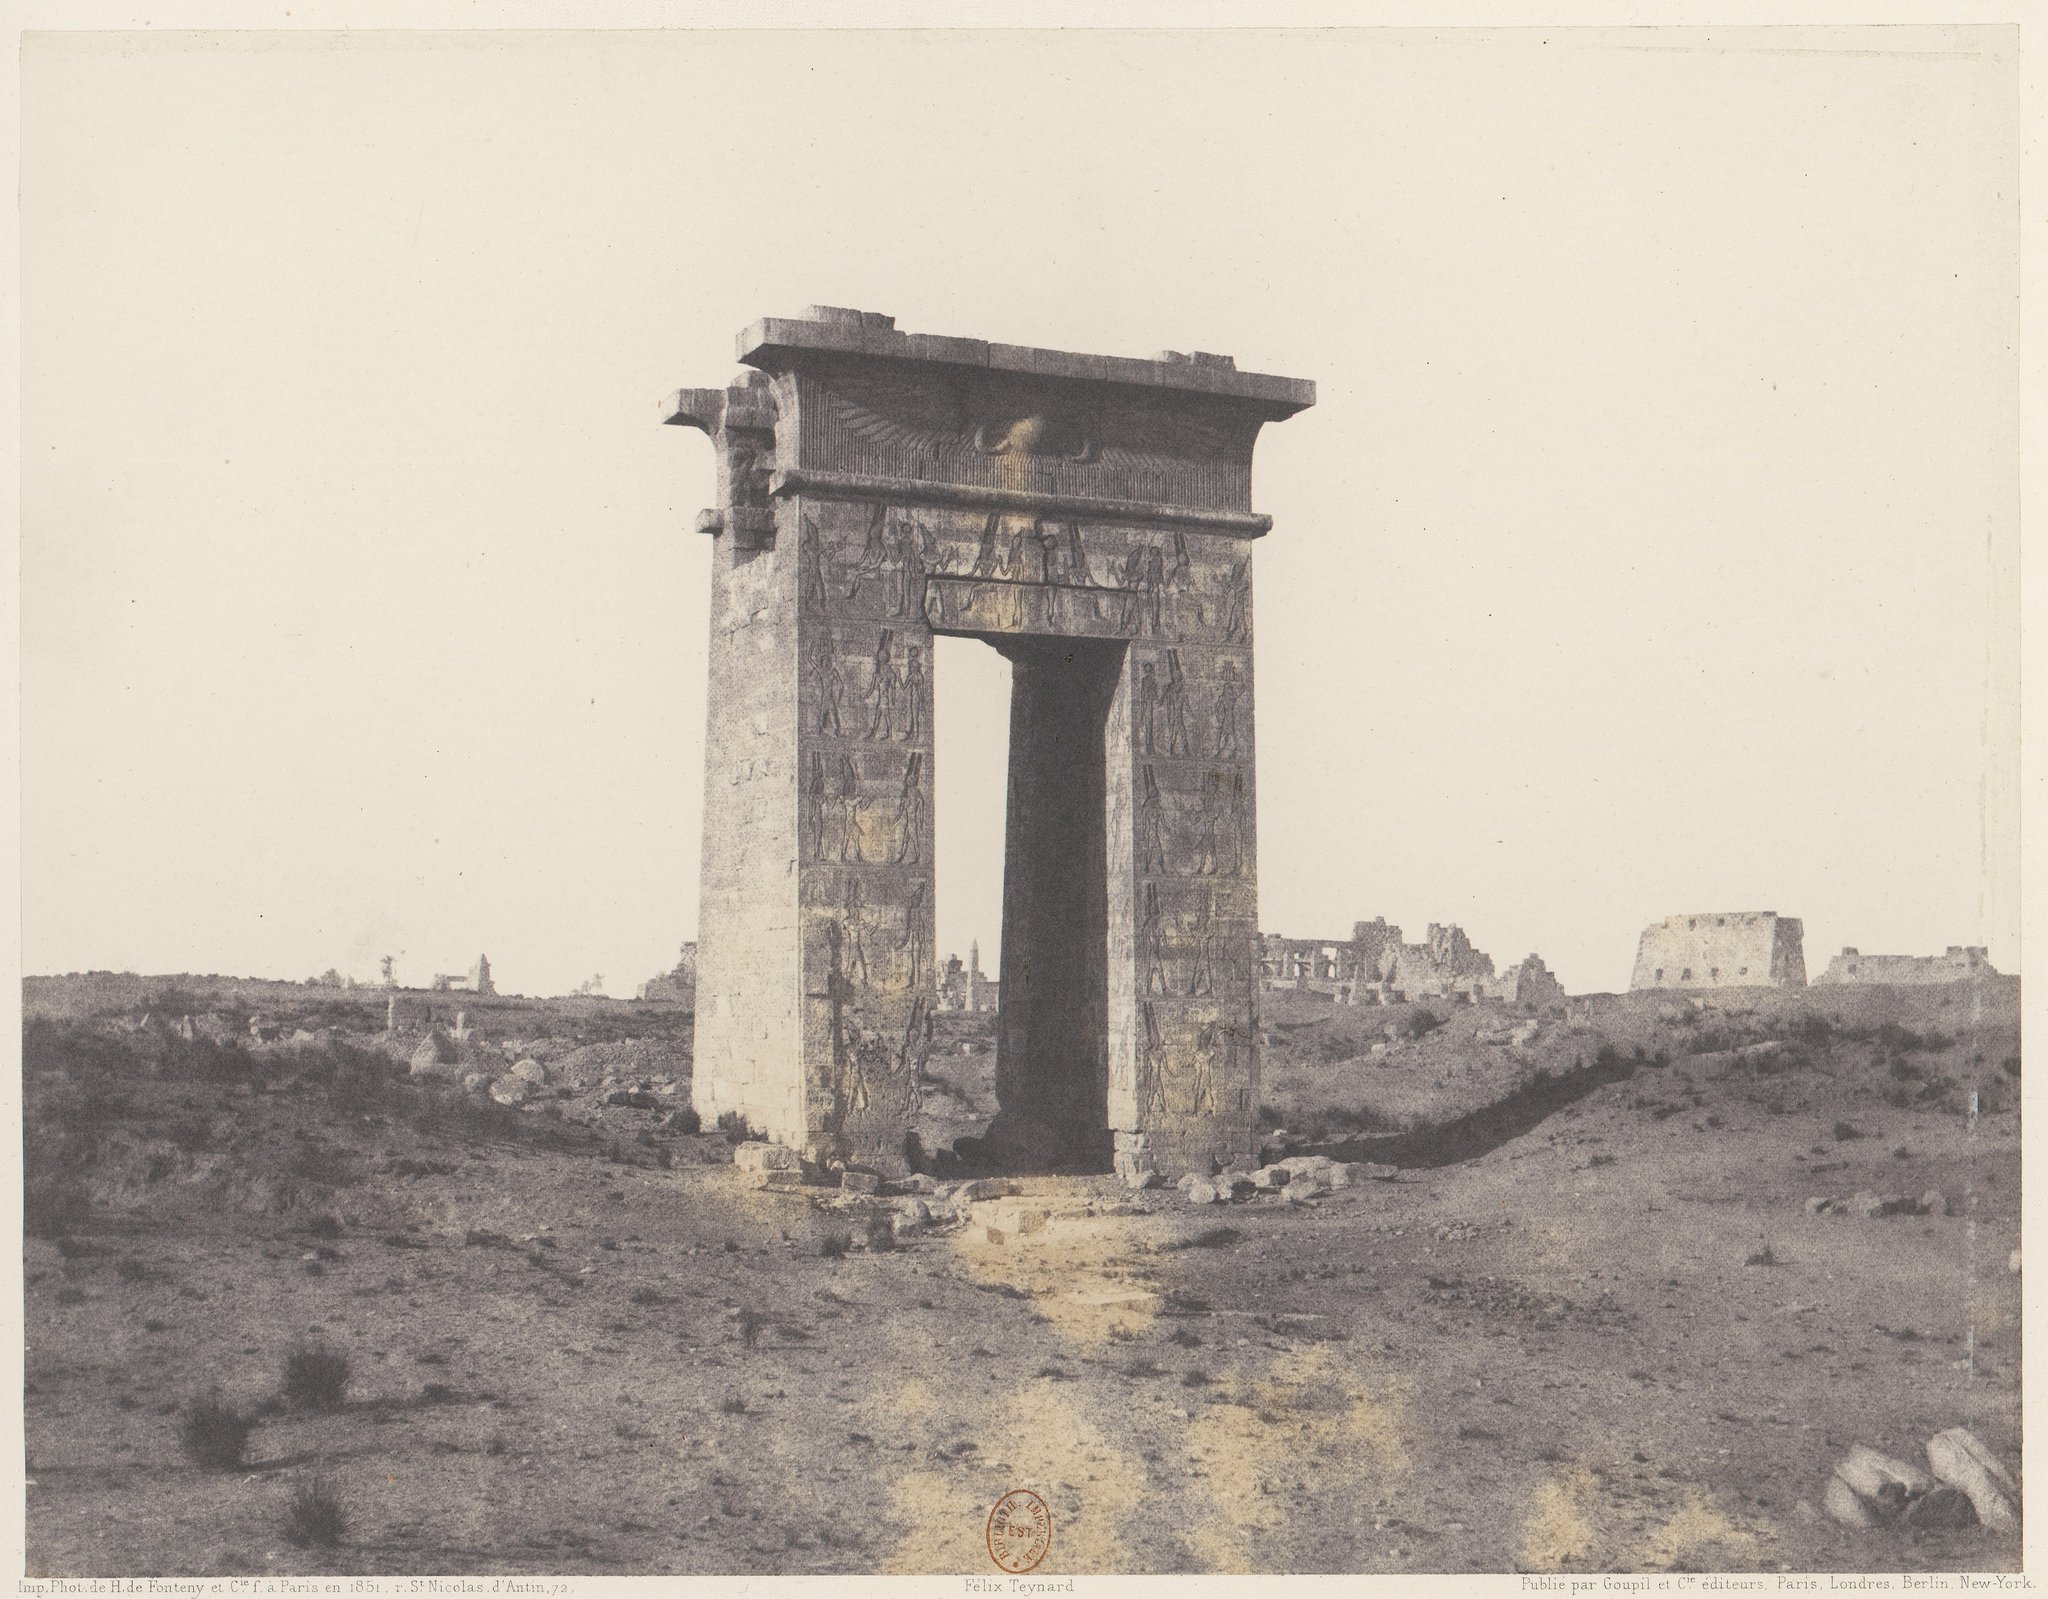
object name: photograph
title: Karnak (Thèbes), Grande Porte du Nord Vue du Point X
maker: félix teynard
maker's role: artist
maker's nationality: french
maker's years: 1817-1892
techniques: paper negative, salted paper print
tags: architecture,ruins